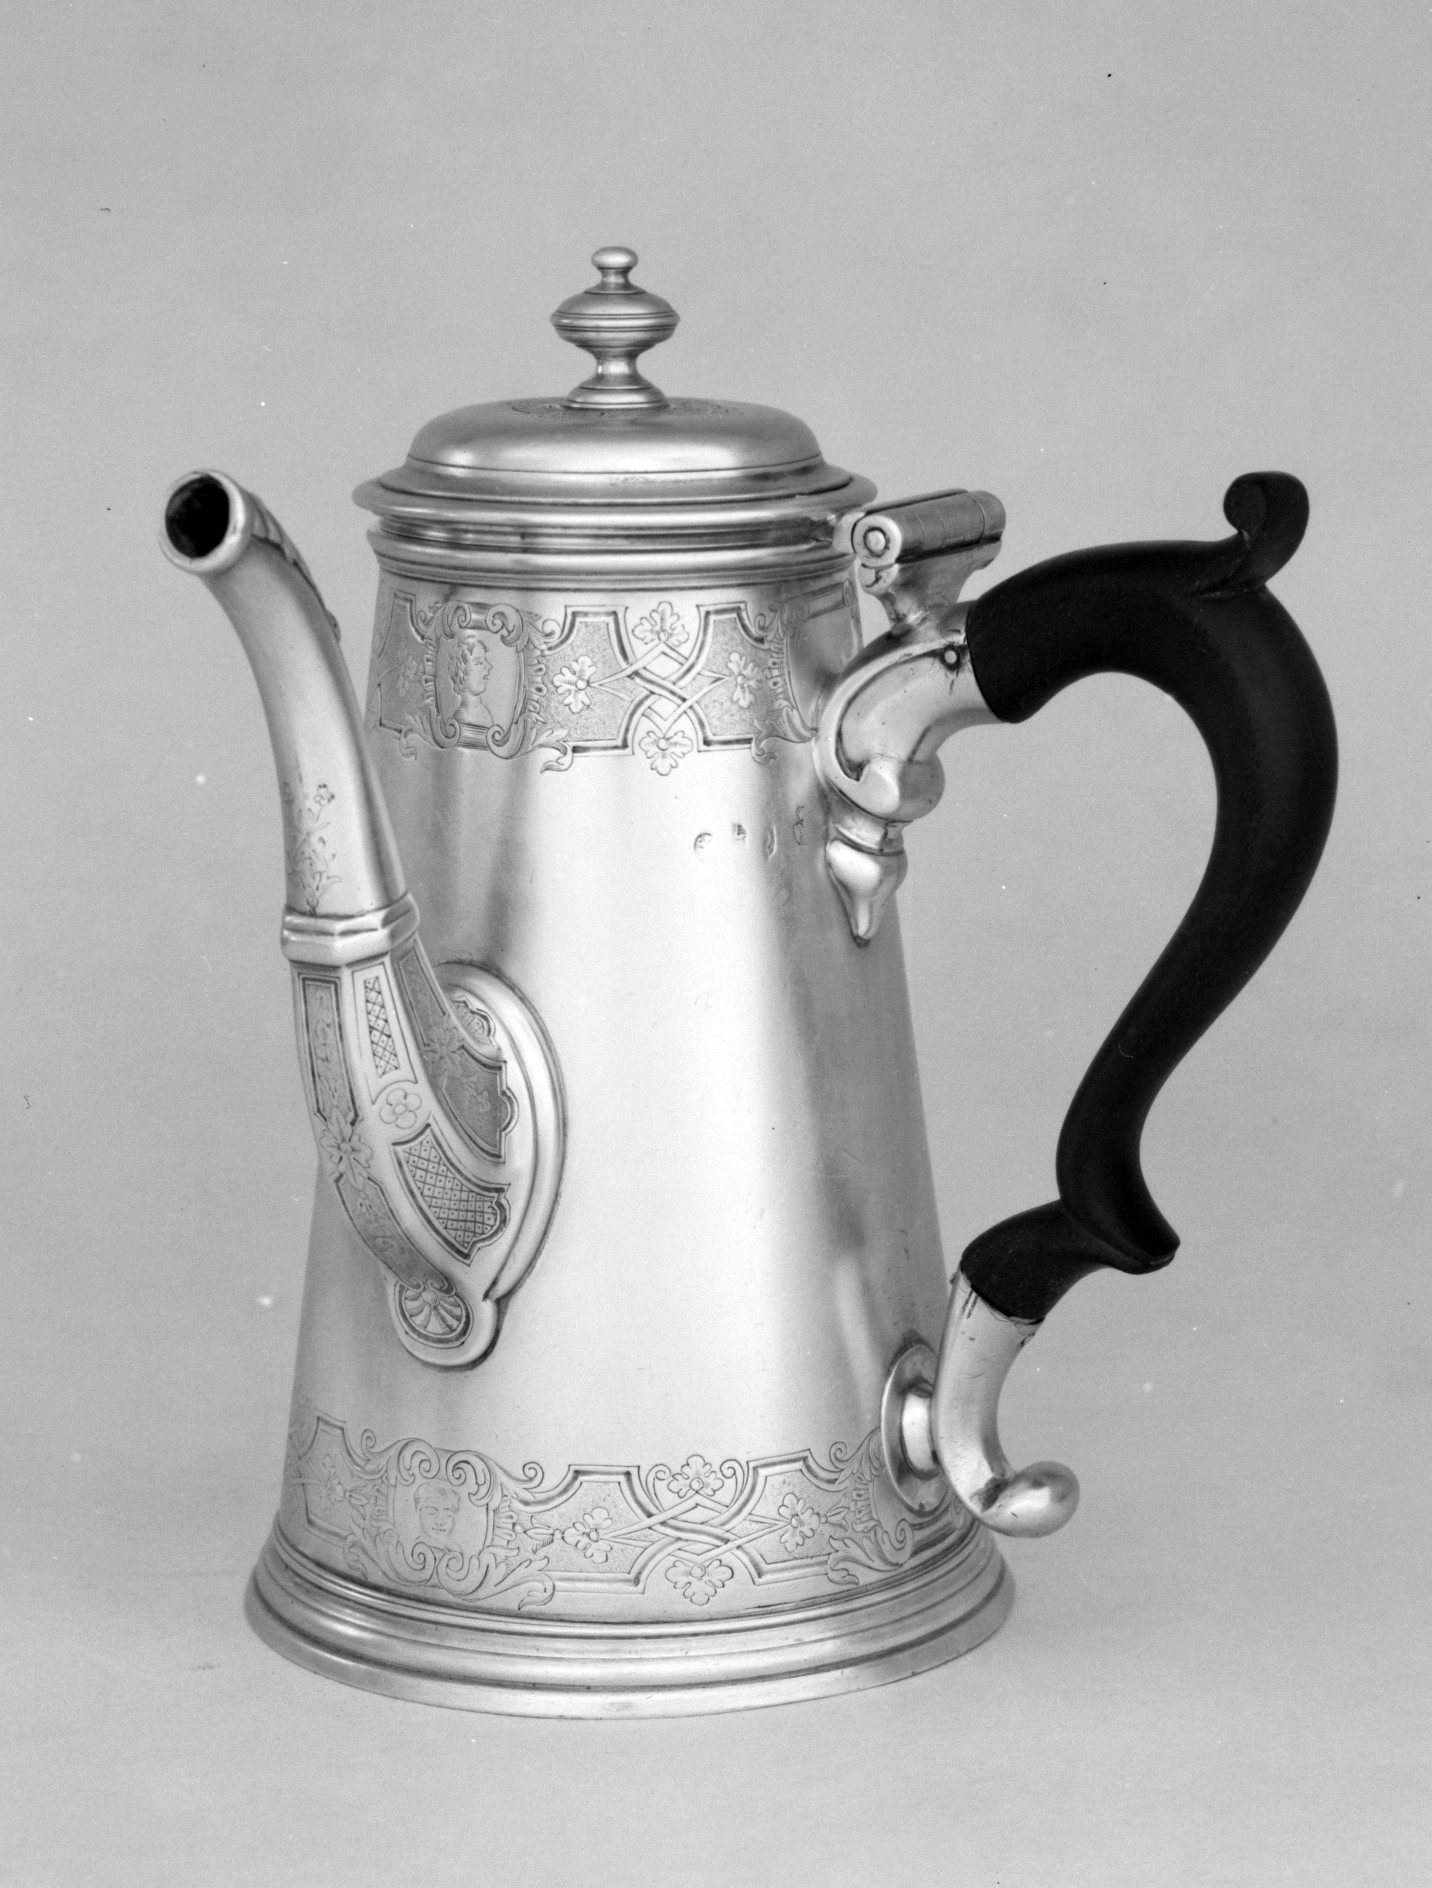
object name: coffeepot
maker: phillip kinnersly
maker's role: maker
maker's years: 1716-1736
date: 1736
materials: silver, wood